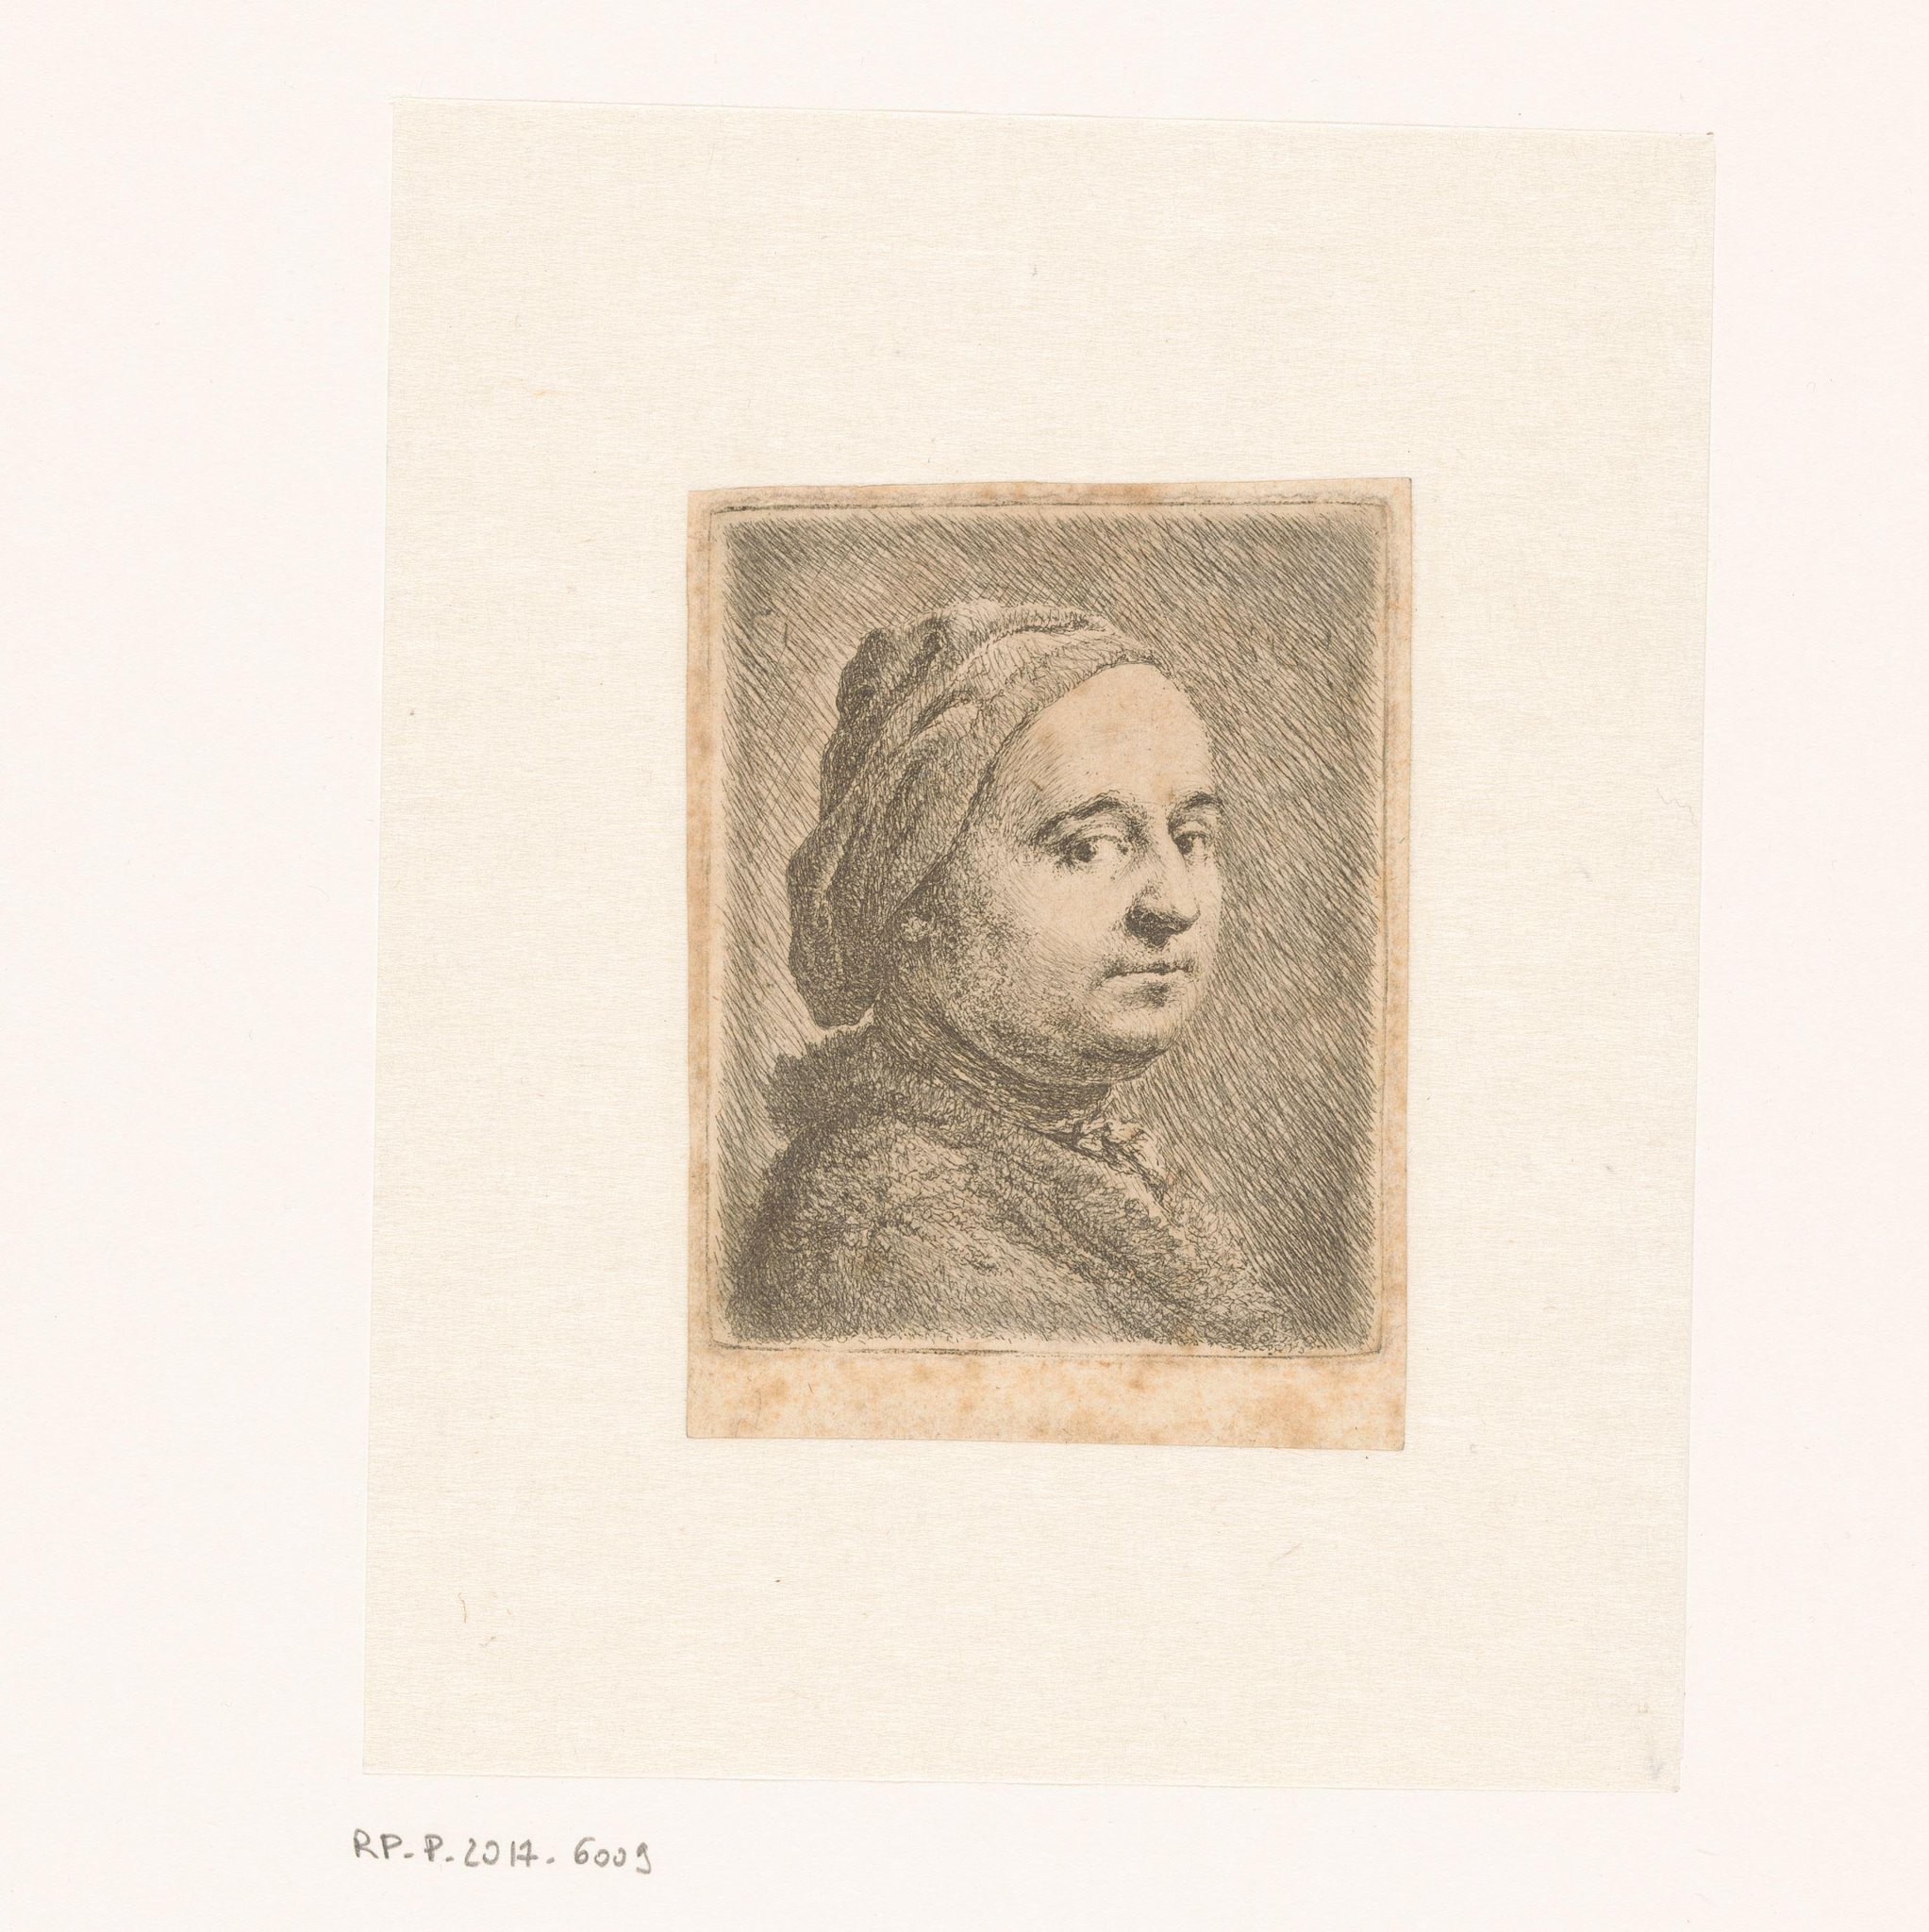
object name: print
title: Portret van een man met pet en bontjas.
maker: johann heinrich rode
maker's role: print maker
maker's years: 1726-1759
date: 1750-1752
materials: paper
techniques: etching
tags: portrait, self-portrait of painter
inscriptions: collector's mark: Lugt 2228, collector's mark: Lugt 2656, collector's mark: Lugt 2760